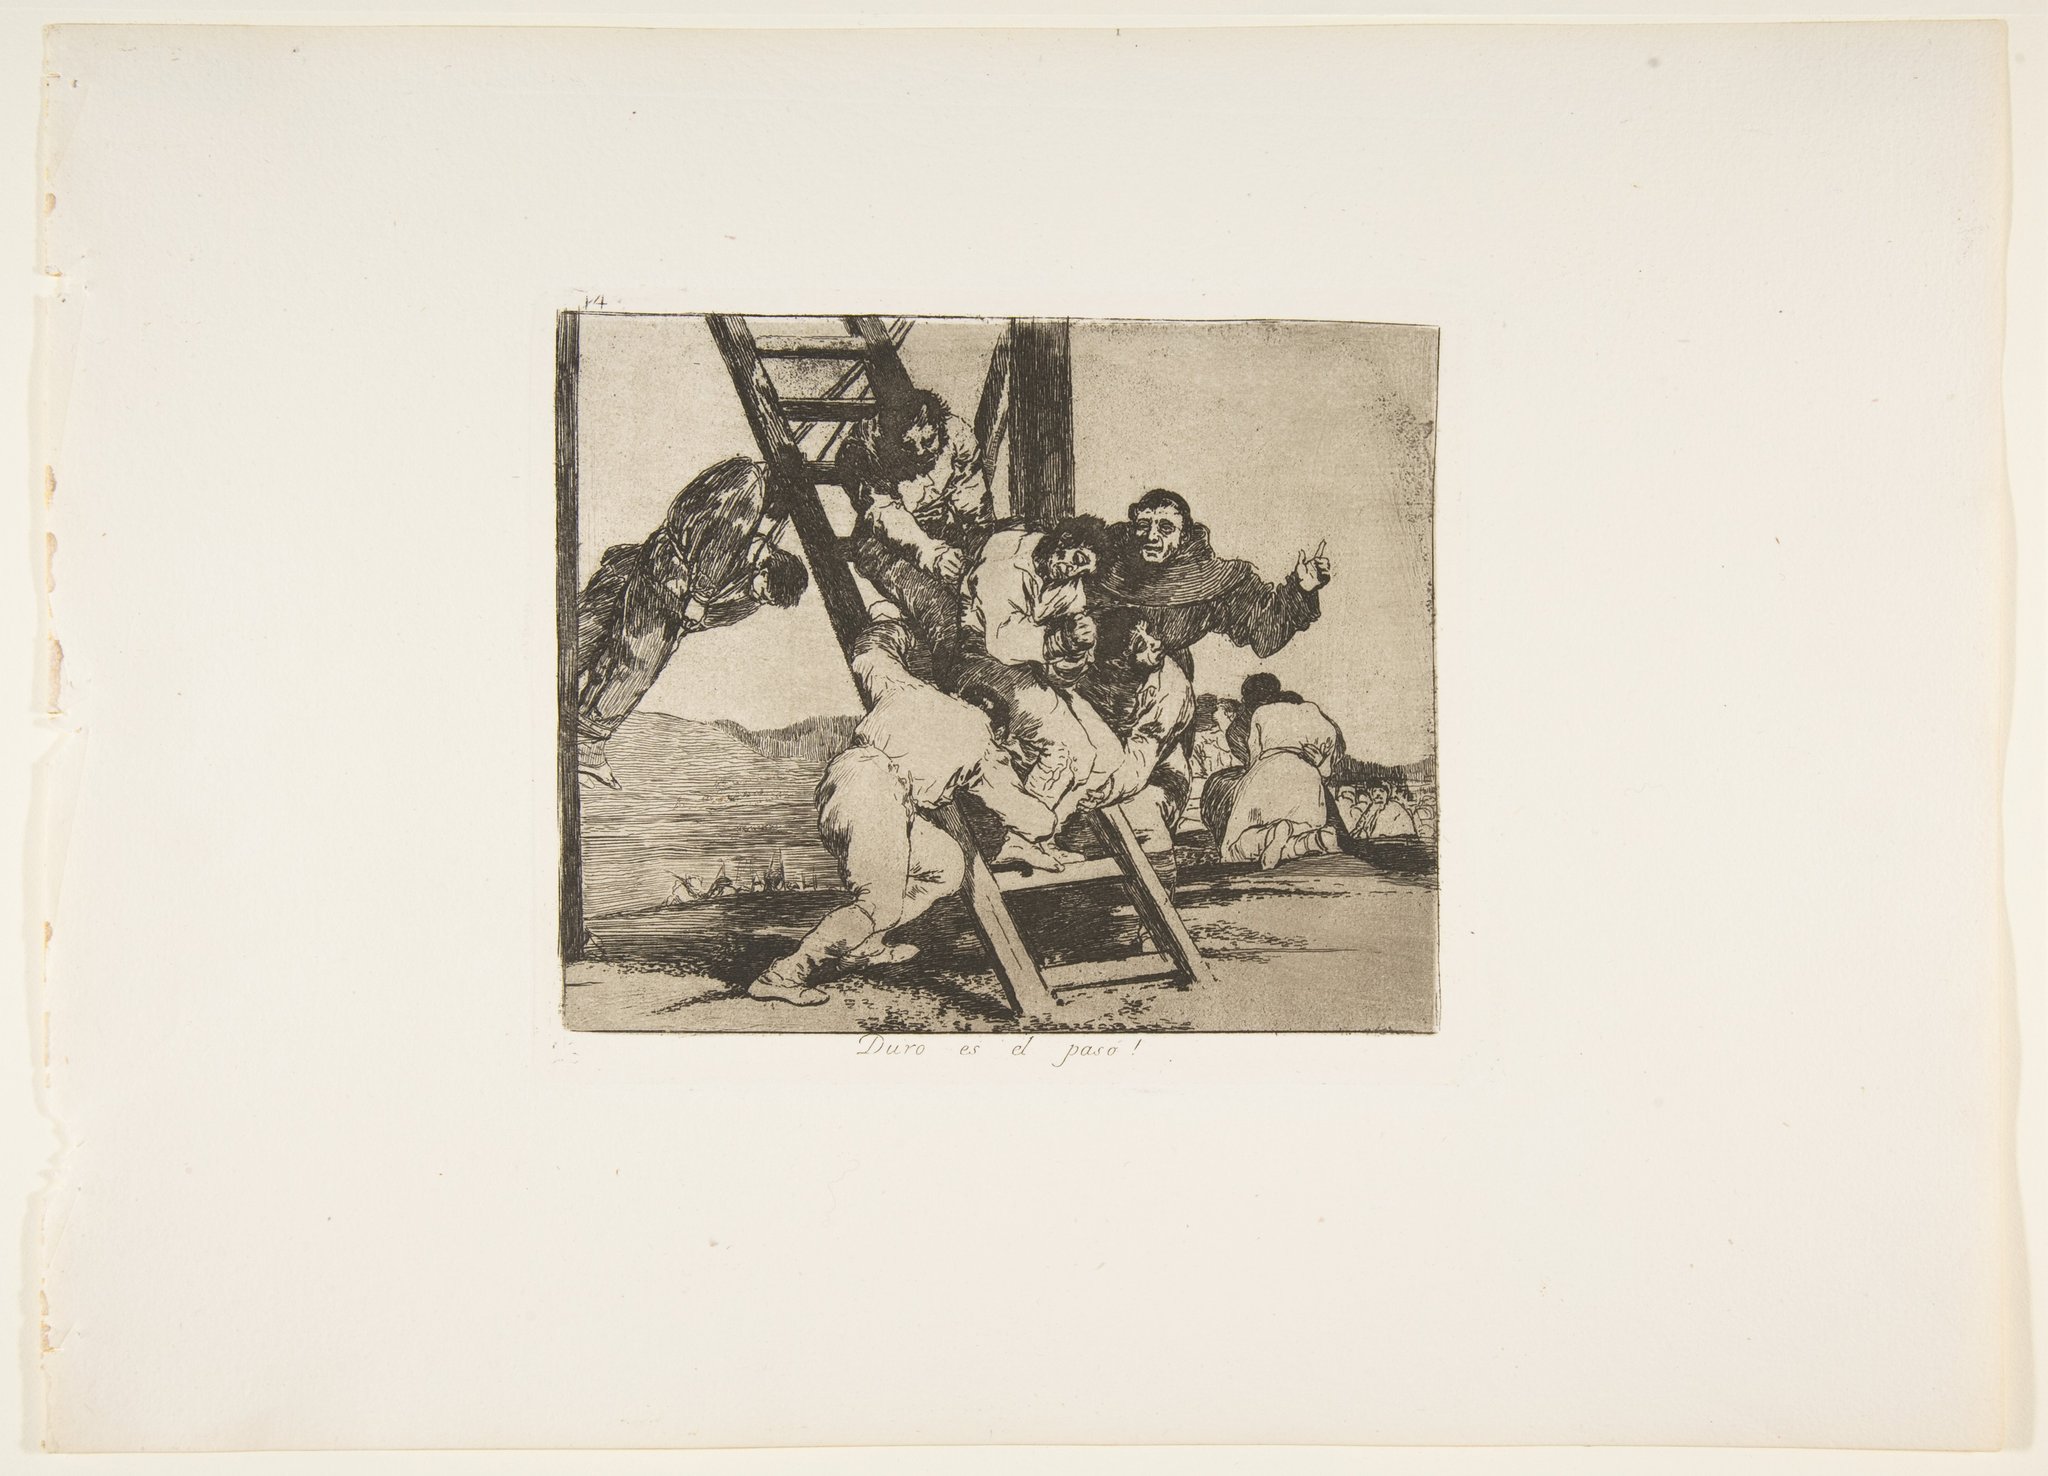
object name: print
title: Plate 14 from "The Disasters of War" (Los Desastres de la Guerra): It's a hard step! (Duro es el paso!)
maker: goya (francisco de goya y lucientes)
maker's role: artist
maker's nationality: spanish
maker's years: 1746-1828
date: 1810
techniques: engraving, burnishing, drypoint, etching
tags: men,ladders